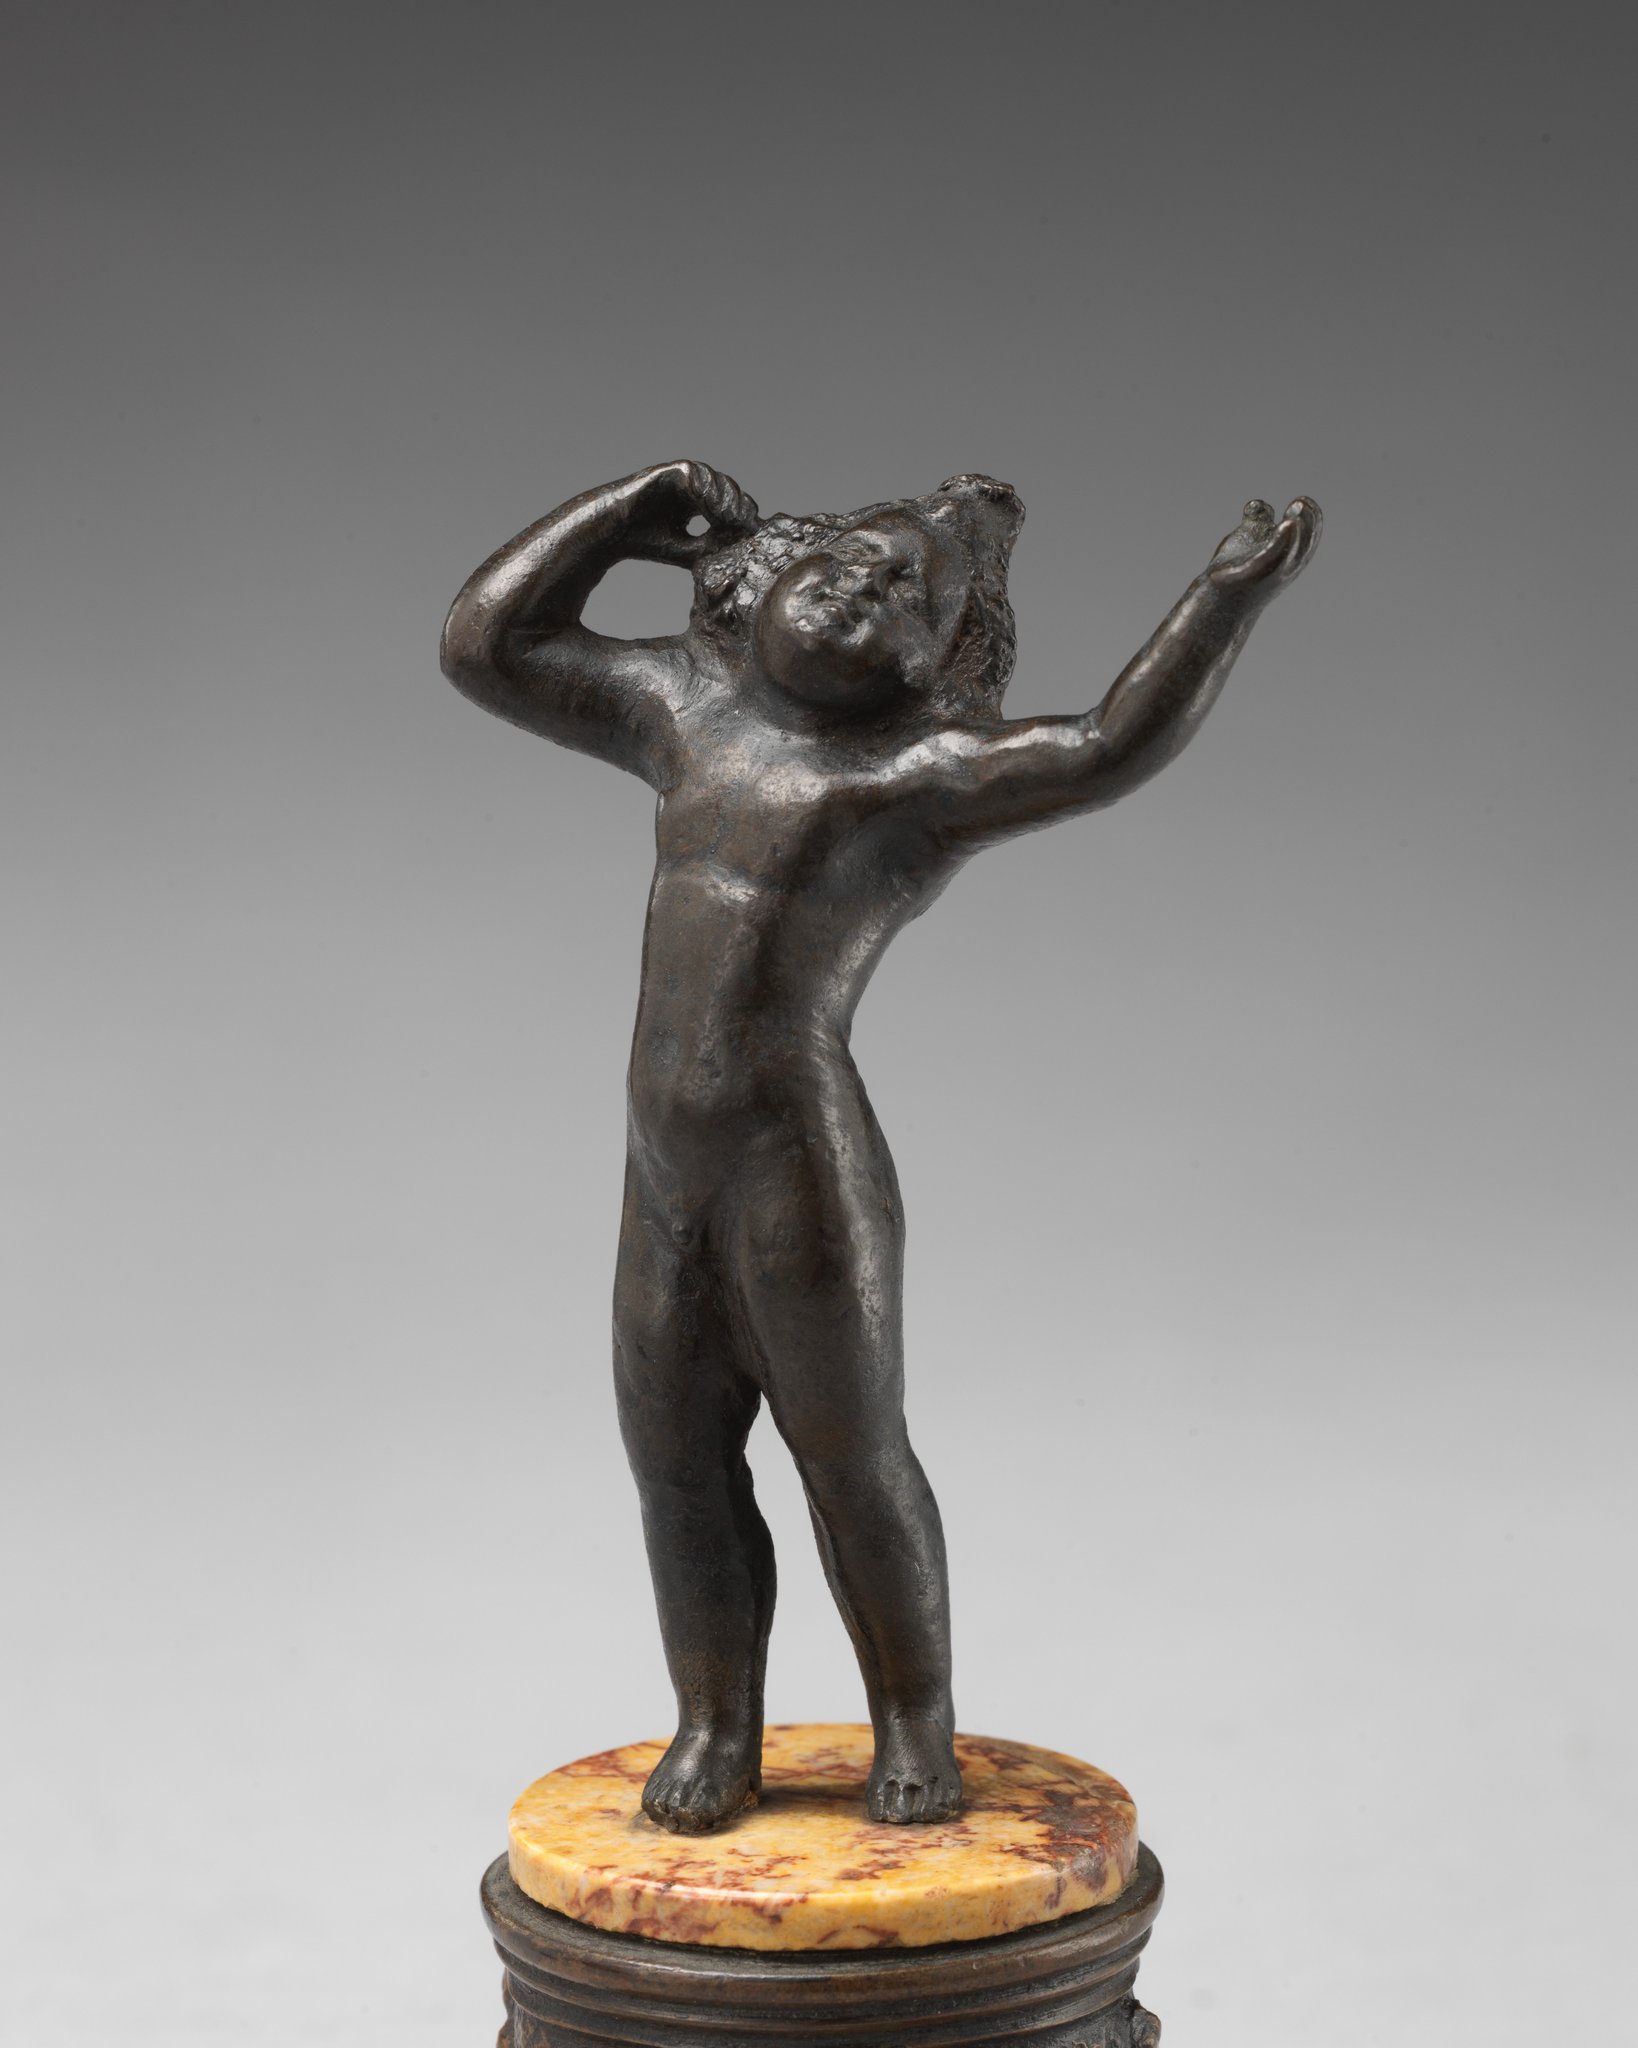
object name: statuette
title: Cupid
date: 1501-1600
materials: bronze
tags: cupid